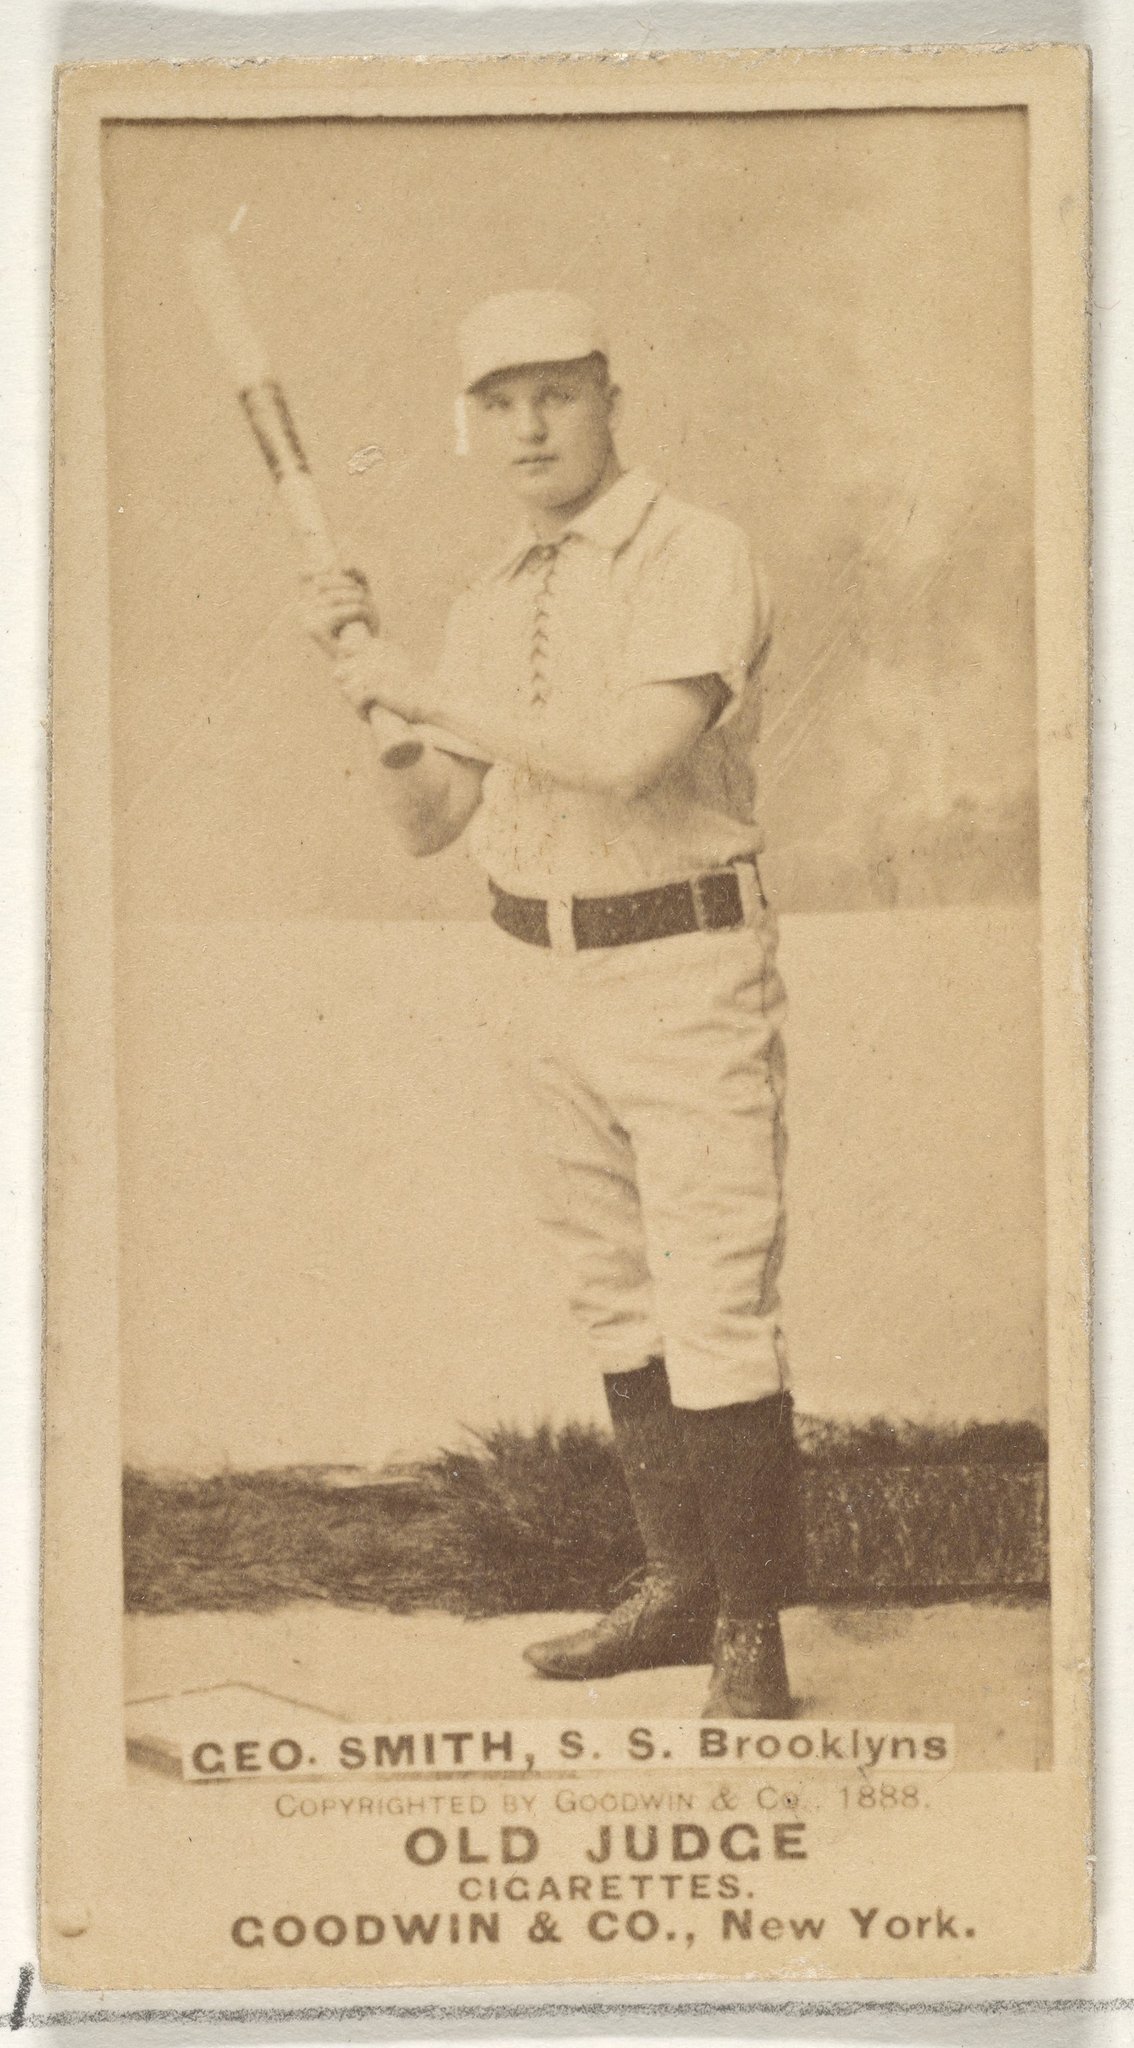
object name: baseball card, photograph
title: Geo. Smith, Shortstop, Brooklyn Bridegrooms, from the Old Judge series (N172) for Old Judge Cigarettes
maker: goodwin & company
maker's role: publisher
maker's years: 1850-1950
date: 1888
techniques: albumen silver print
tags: men,portraits,baseball,athletes